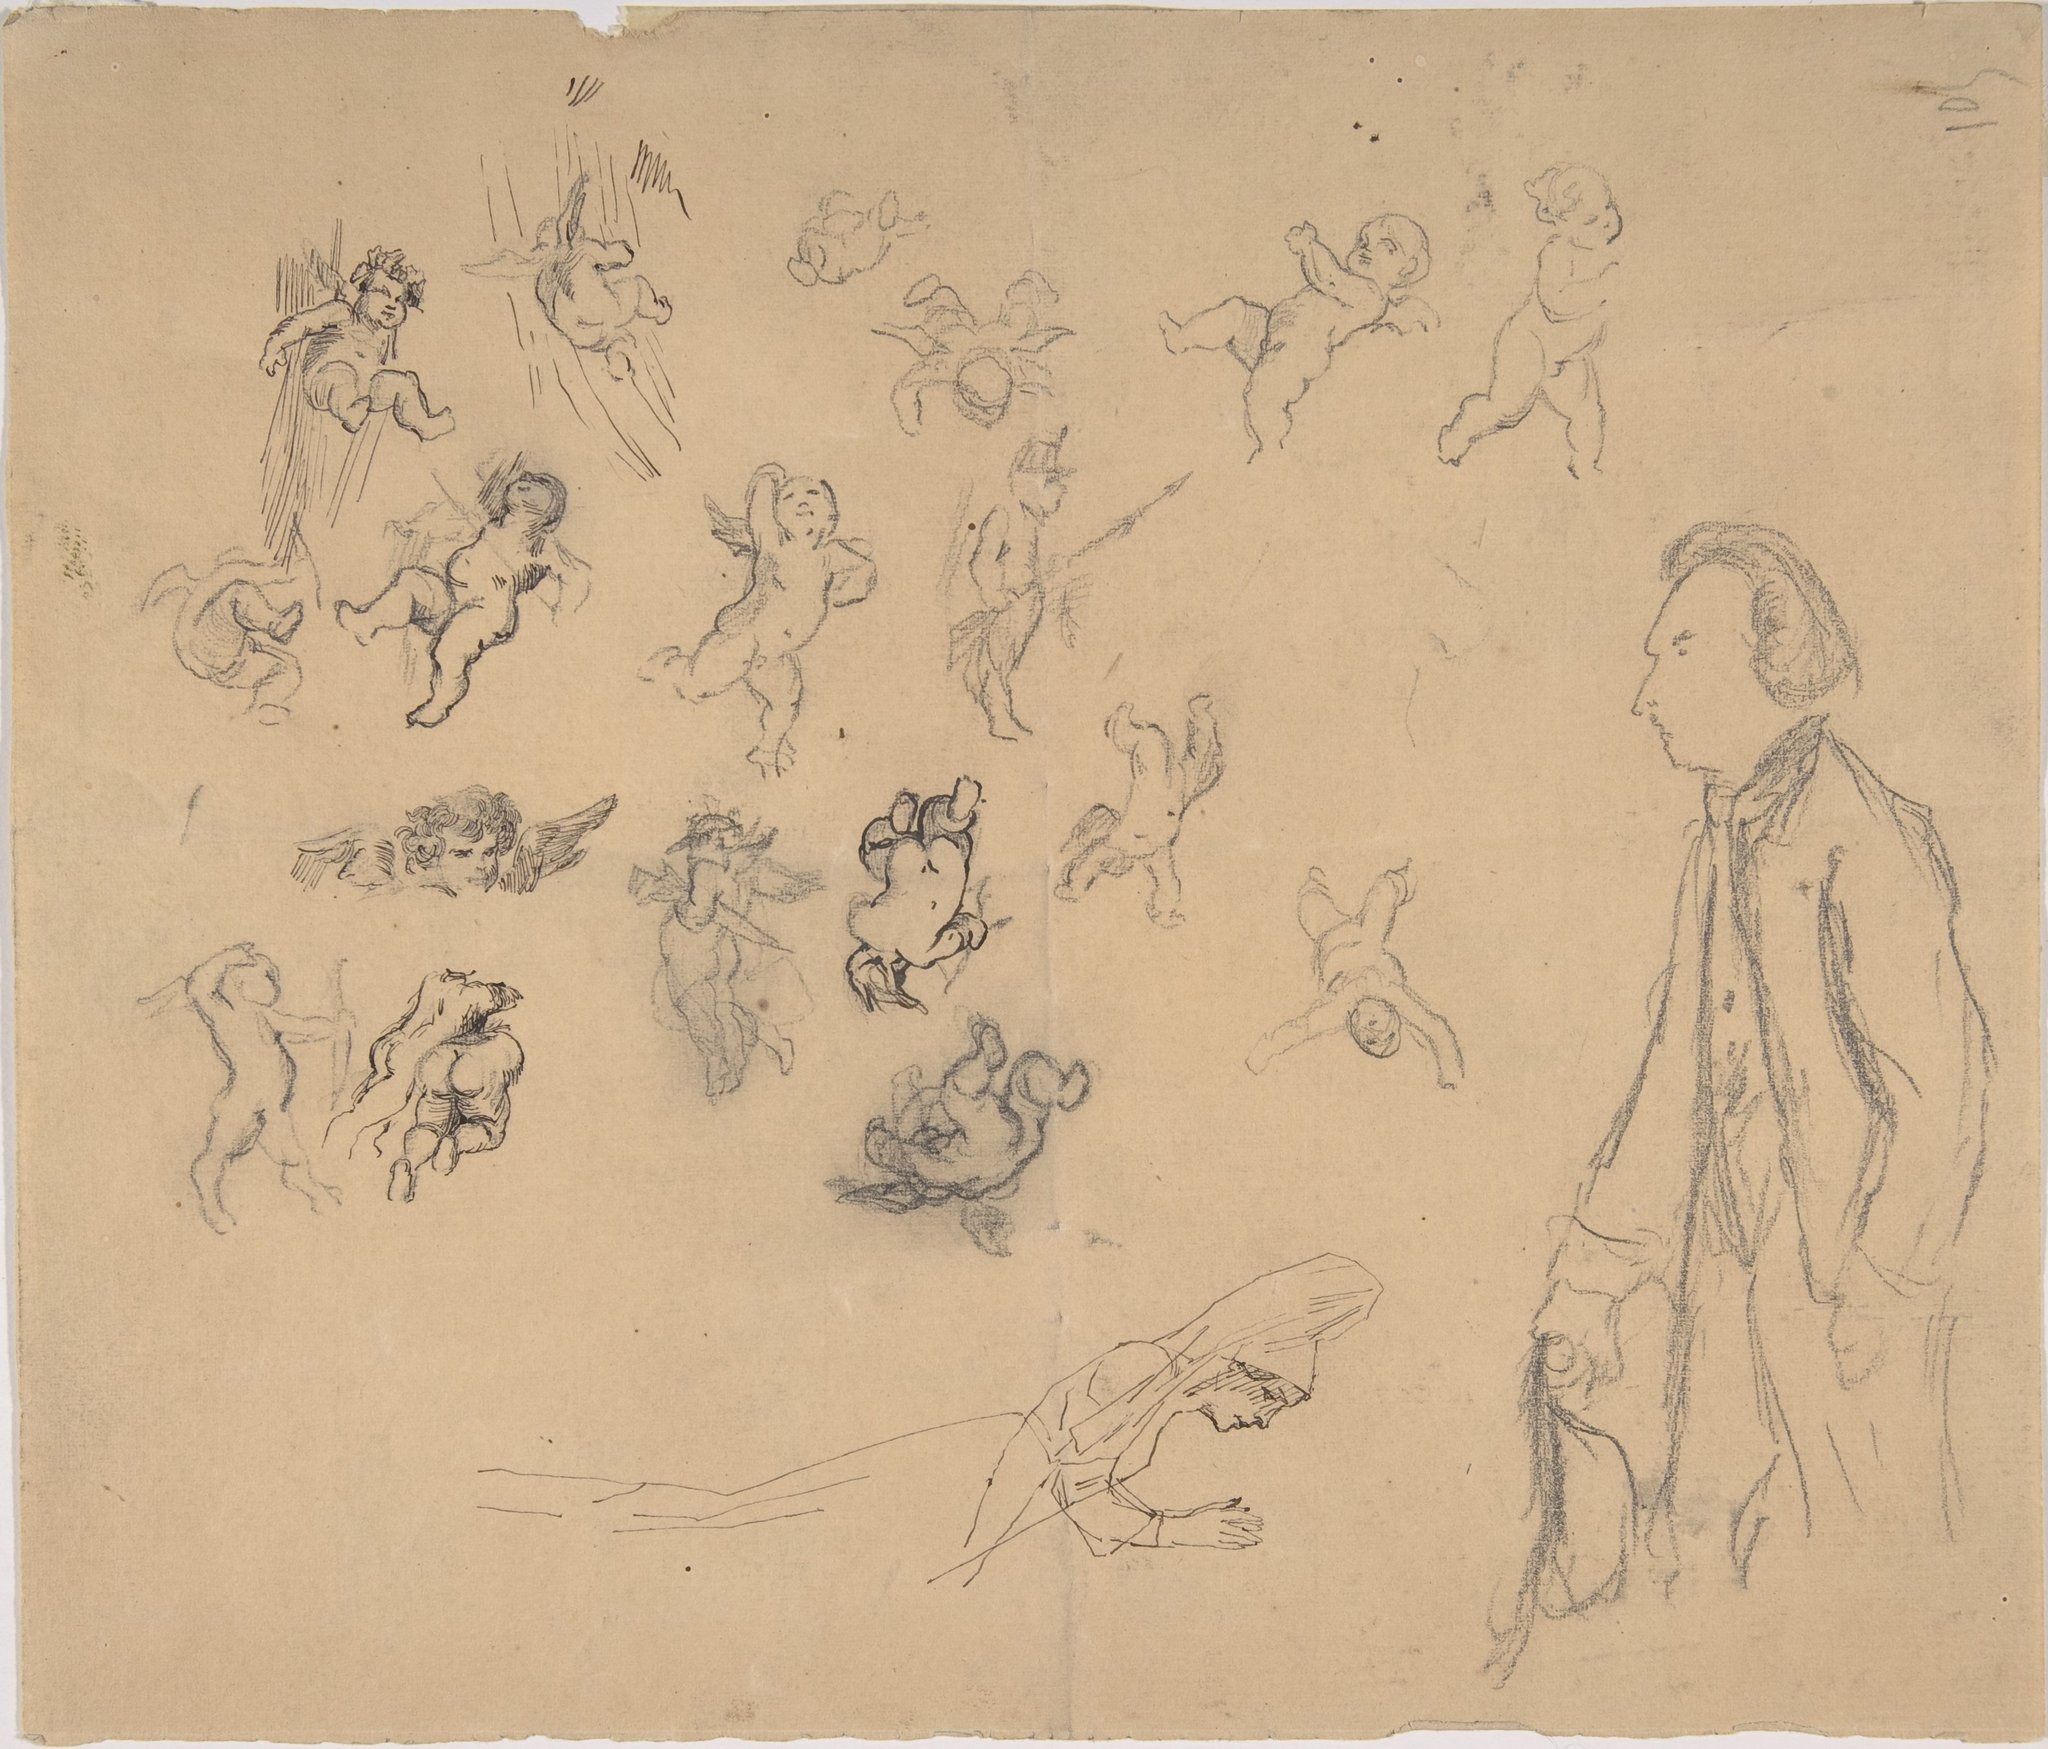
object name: drawing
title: Sheet with putti and several figures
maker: félicien rops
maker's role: artist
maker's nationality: belgian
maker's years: 1833-1898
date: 1833-1898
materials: graphite, ink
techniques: pen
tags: men,women,putti